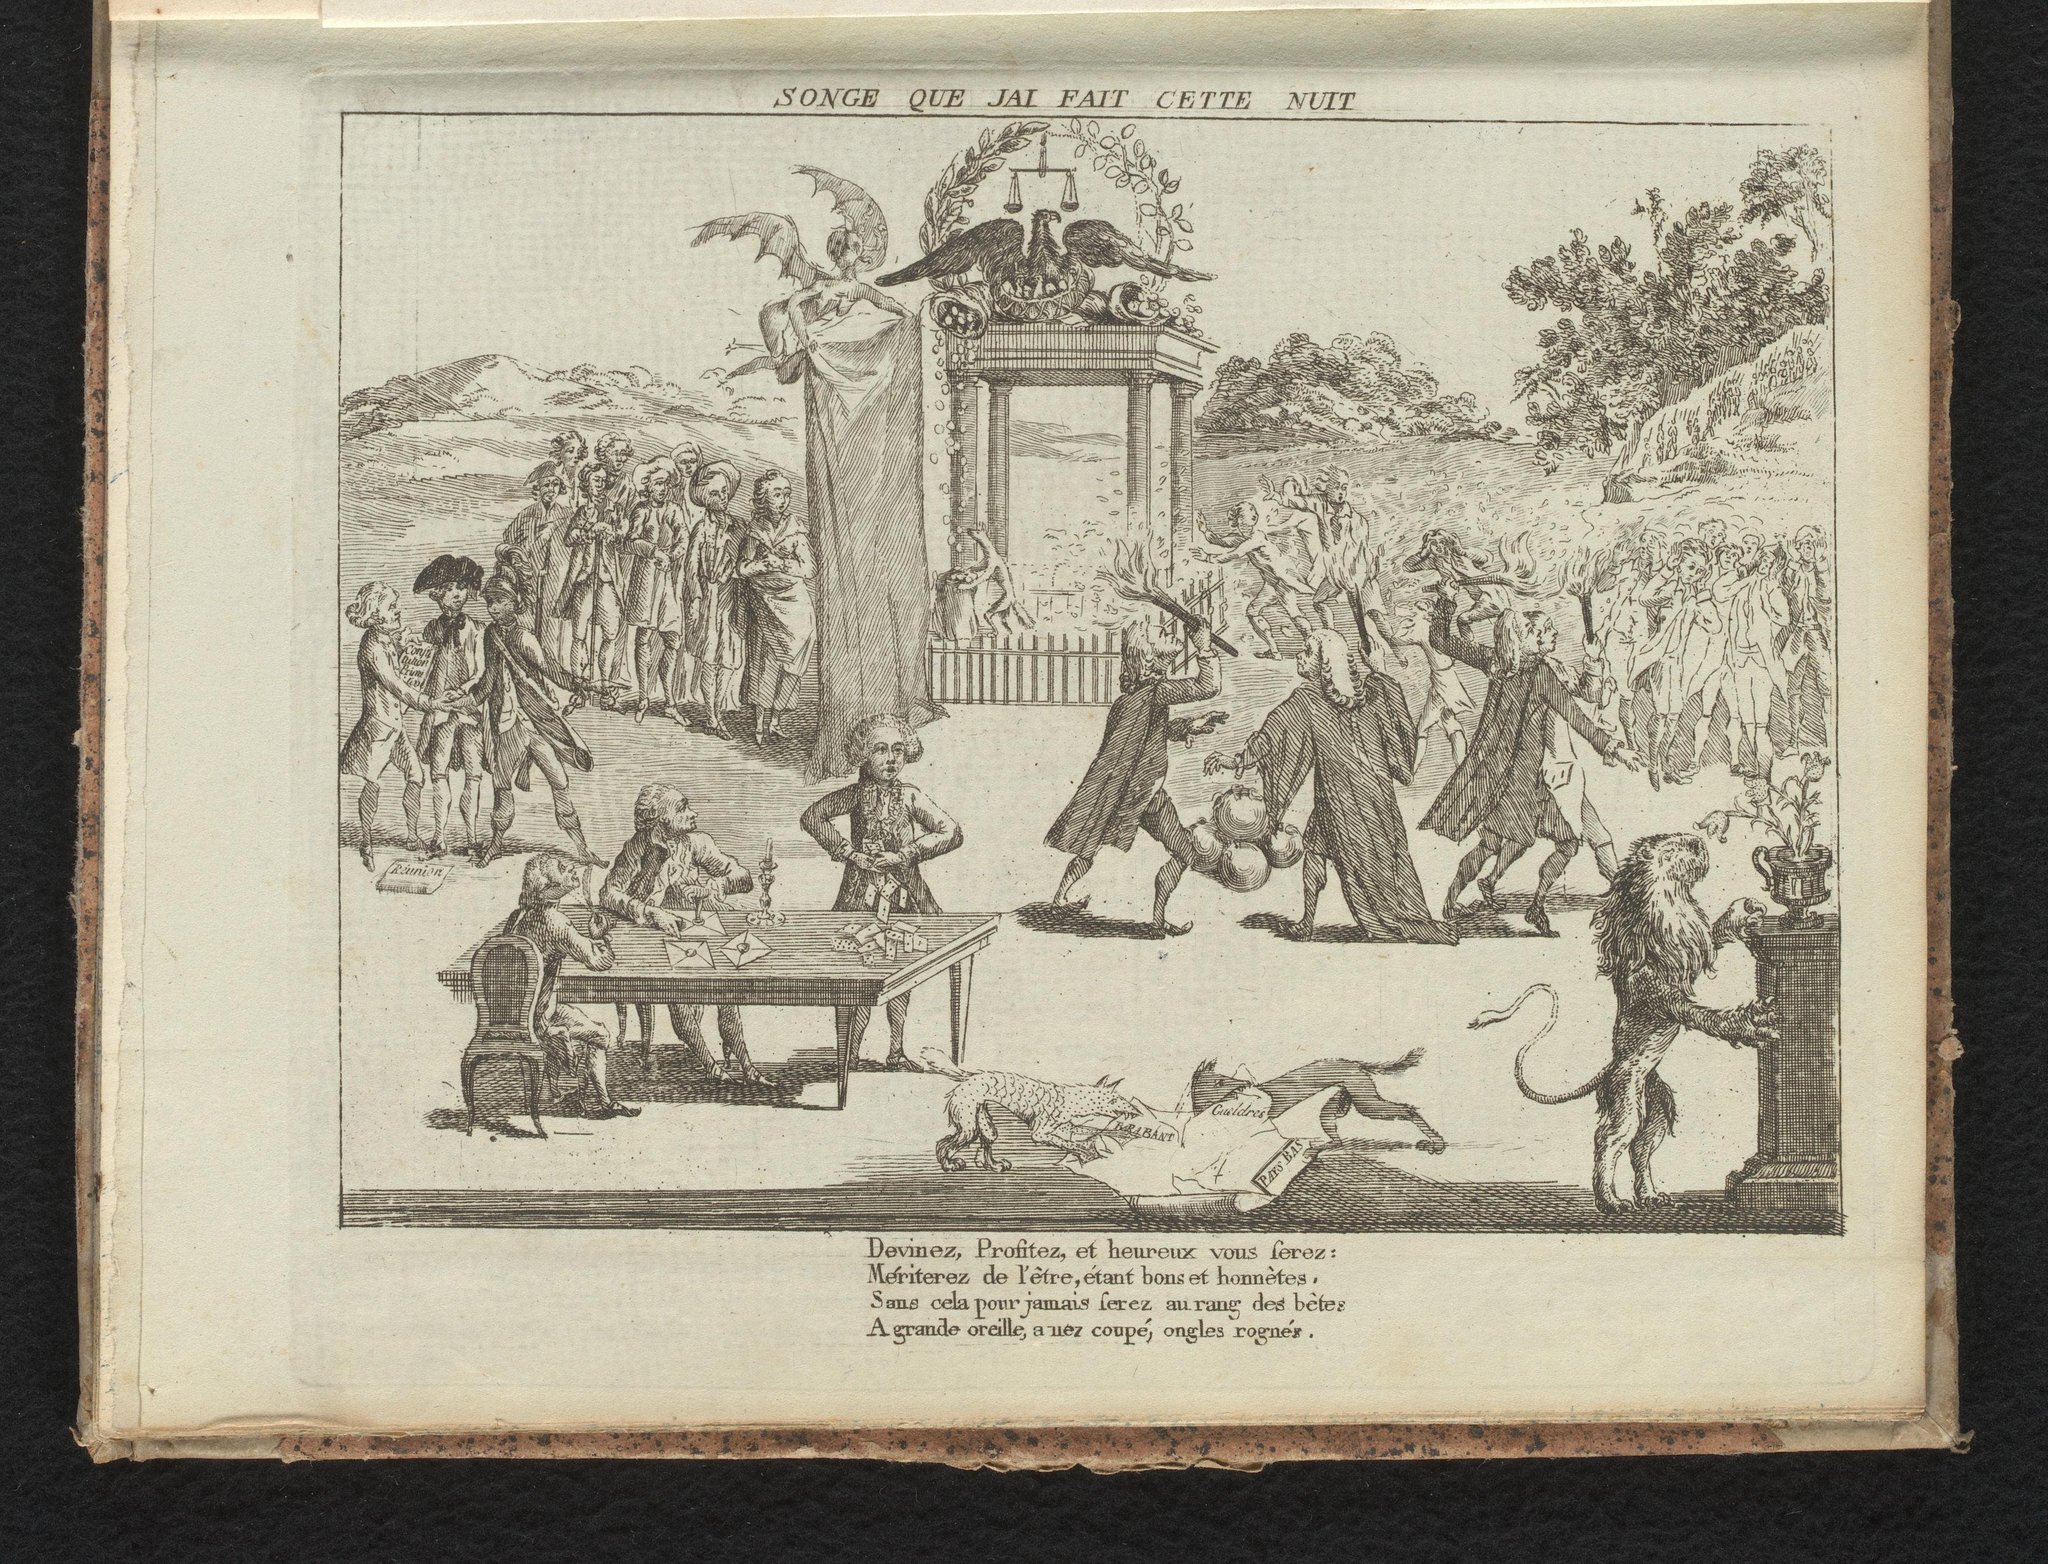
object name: print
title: Droom over de Brabantse omwenteling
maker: Anonymous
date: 1787-1790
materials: paper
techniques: engraving, etching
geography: southern netherlands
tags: dream, brabant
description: Spotprent met een fantastische voorstelling van een droom of nachtmerrie over de Brabantse omwenteling. Met vierregelig Frans vers. Onderdeel van de gebundelde verzameling prenten betrekking hebbend op de gebeurtenissen van de Brabantse Omwenteling en de periode 1787-1790.